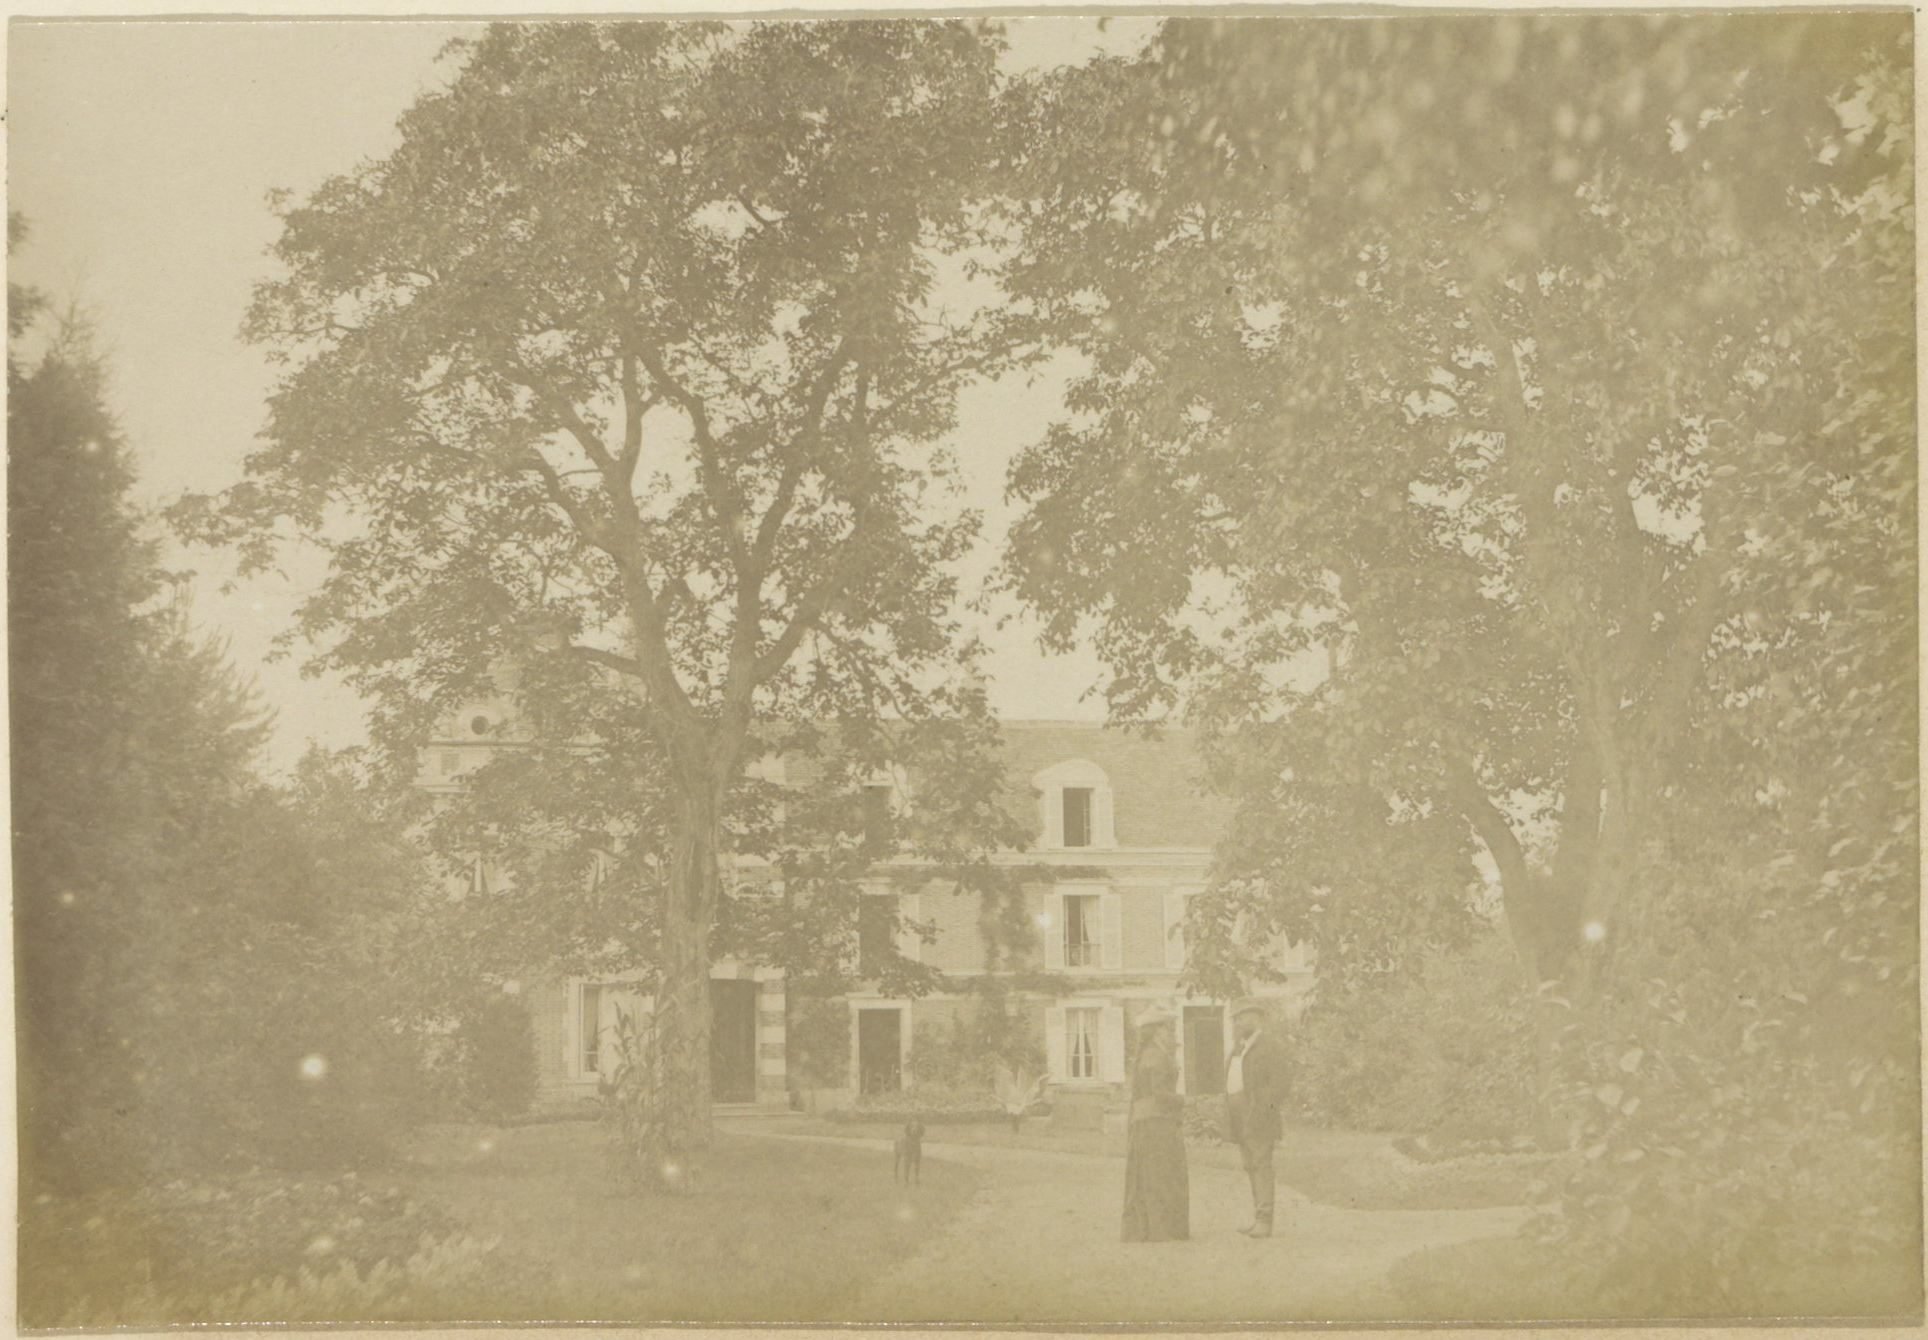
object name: photograph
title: Gezicht op een huis in Frankrijk met op de voorgrond een man, een vrouw en een hond in een tuin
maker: Anonymous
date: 1900-1910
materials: paper, photographic support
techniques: albumen print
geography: france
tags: garden, rural housing, e.g. country-house, villa, cottage, france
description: Onderdeel van Fotoalbum van een Franse amateurfotograaf met opnames van een familie, distilleerderij Delizy & Doistau Fils, het leger en bezienswaardigheden in Frankrijk.